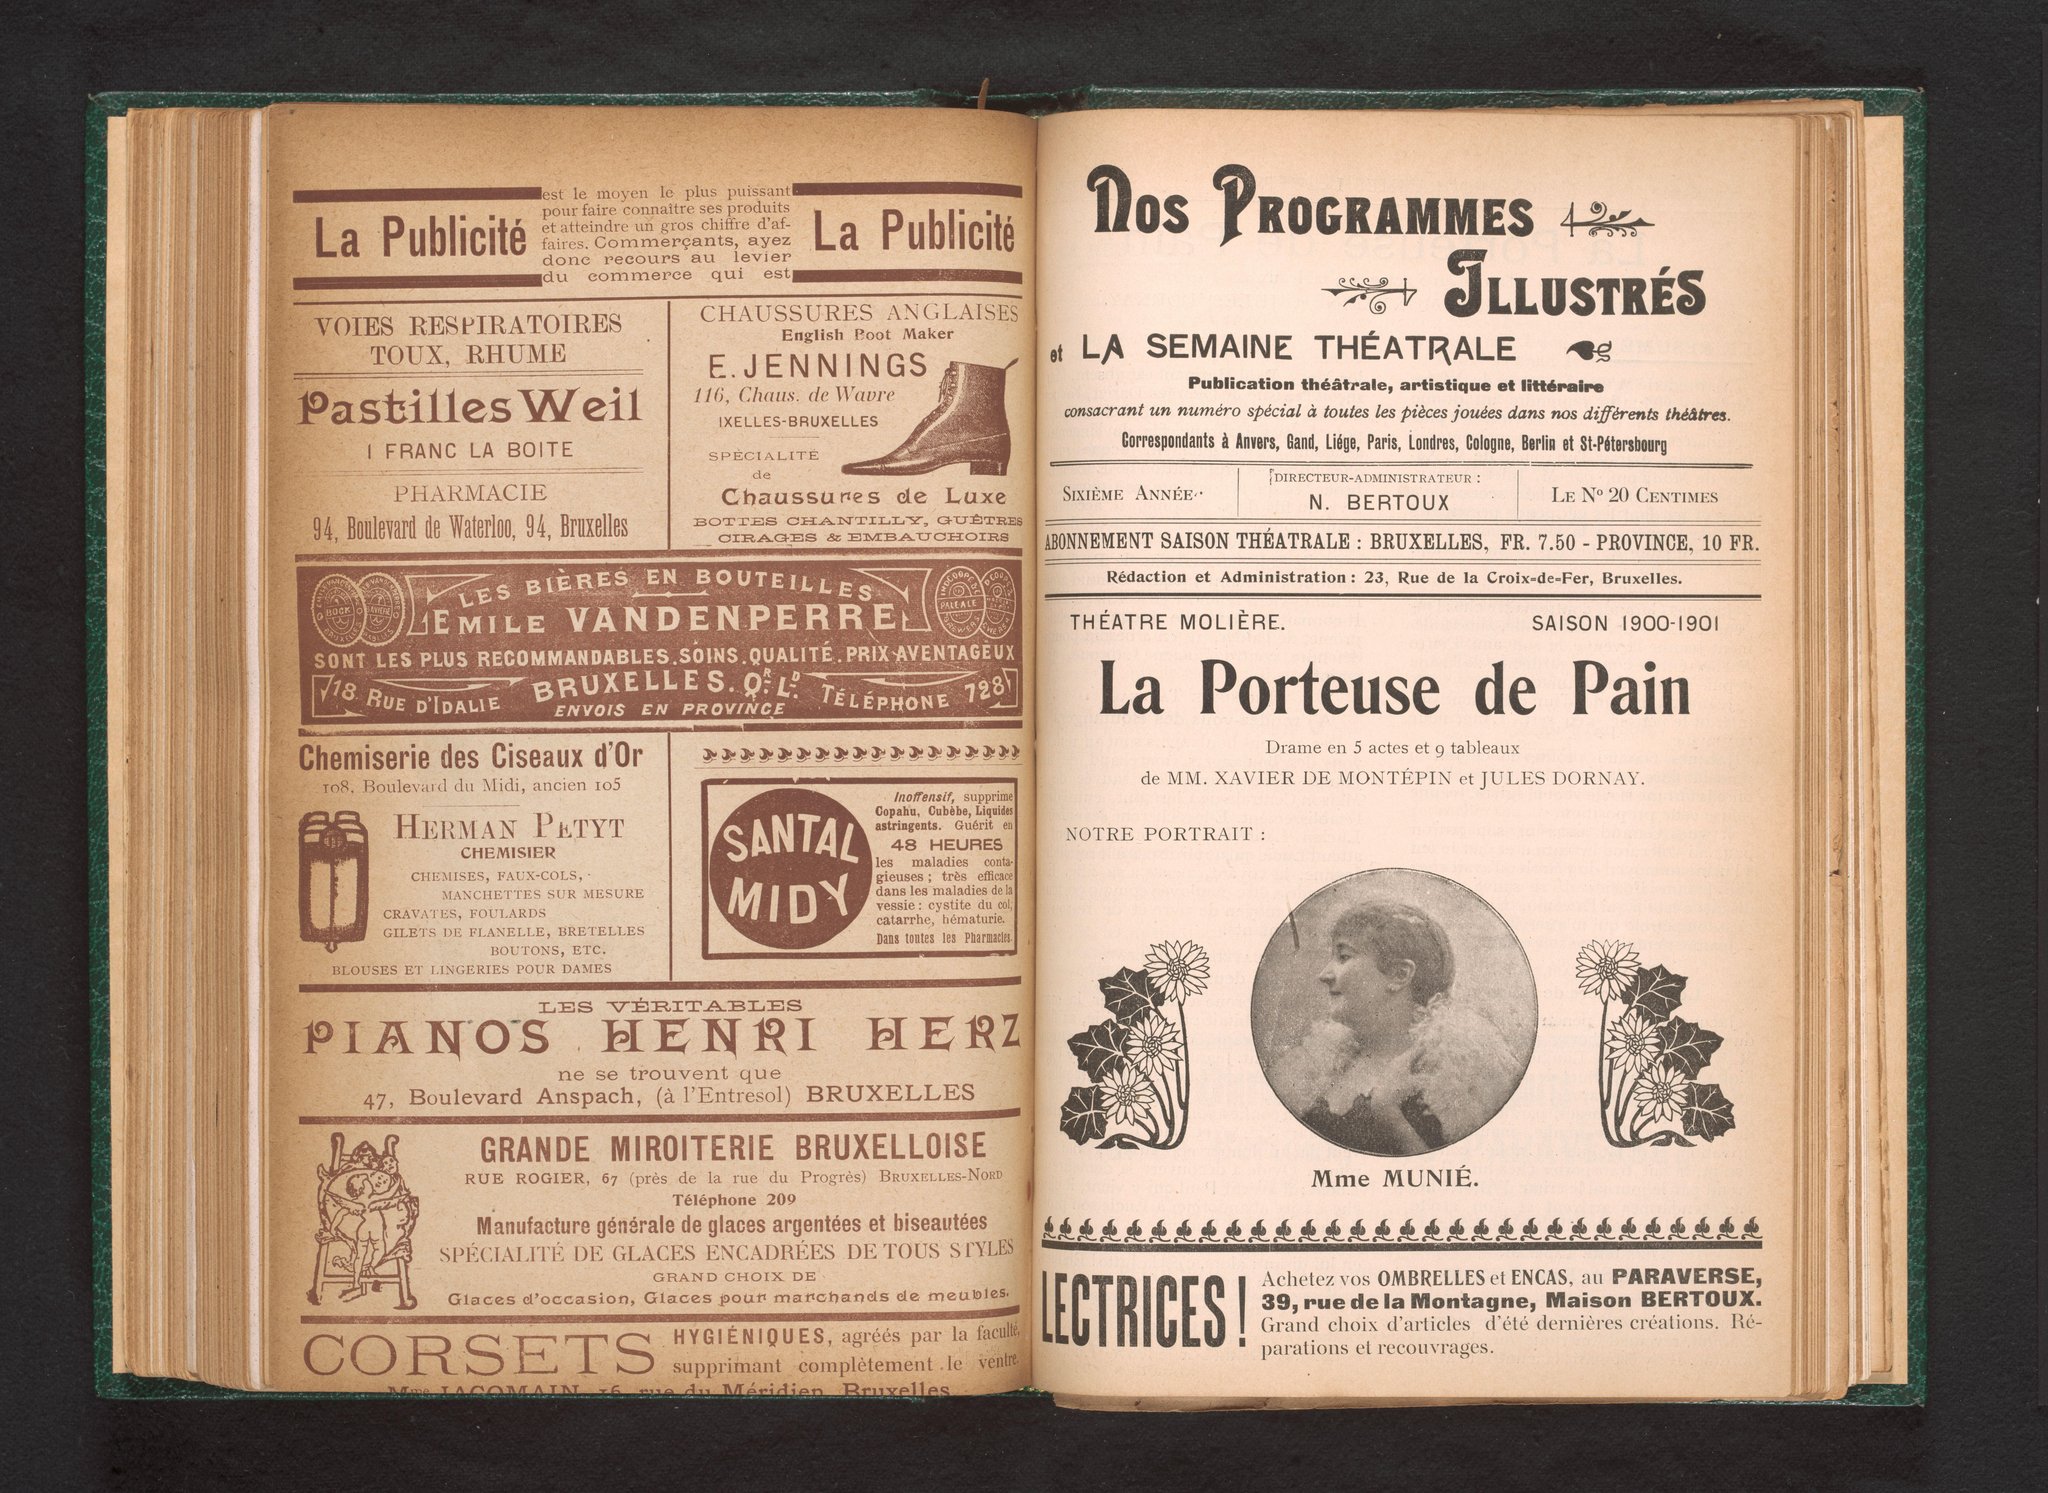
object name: photomechanical print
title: Mme Munié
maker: Anonymous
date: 1895-1900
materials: paper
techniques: autotype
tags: adult man, historical persons